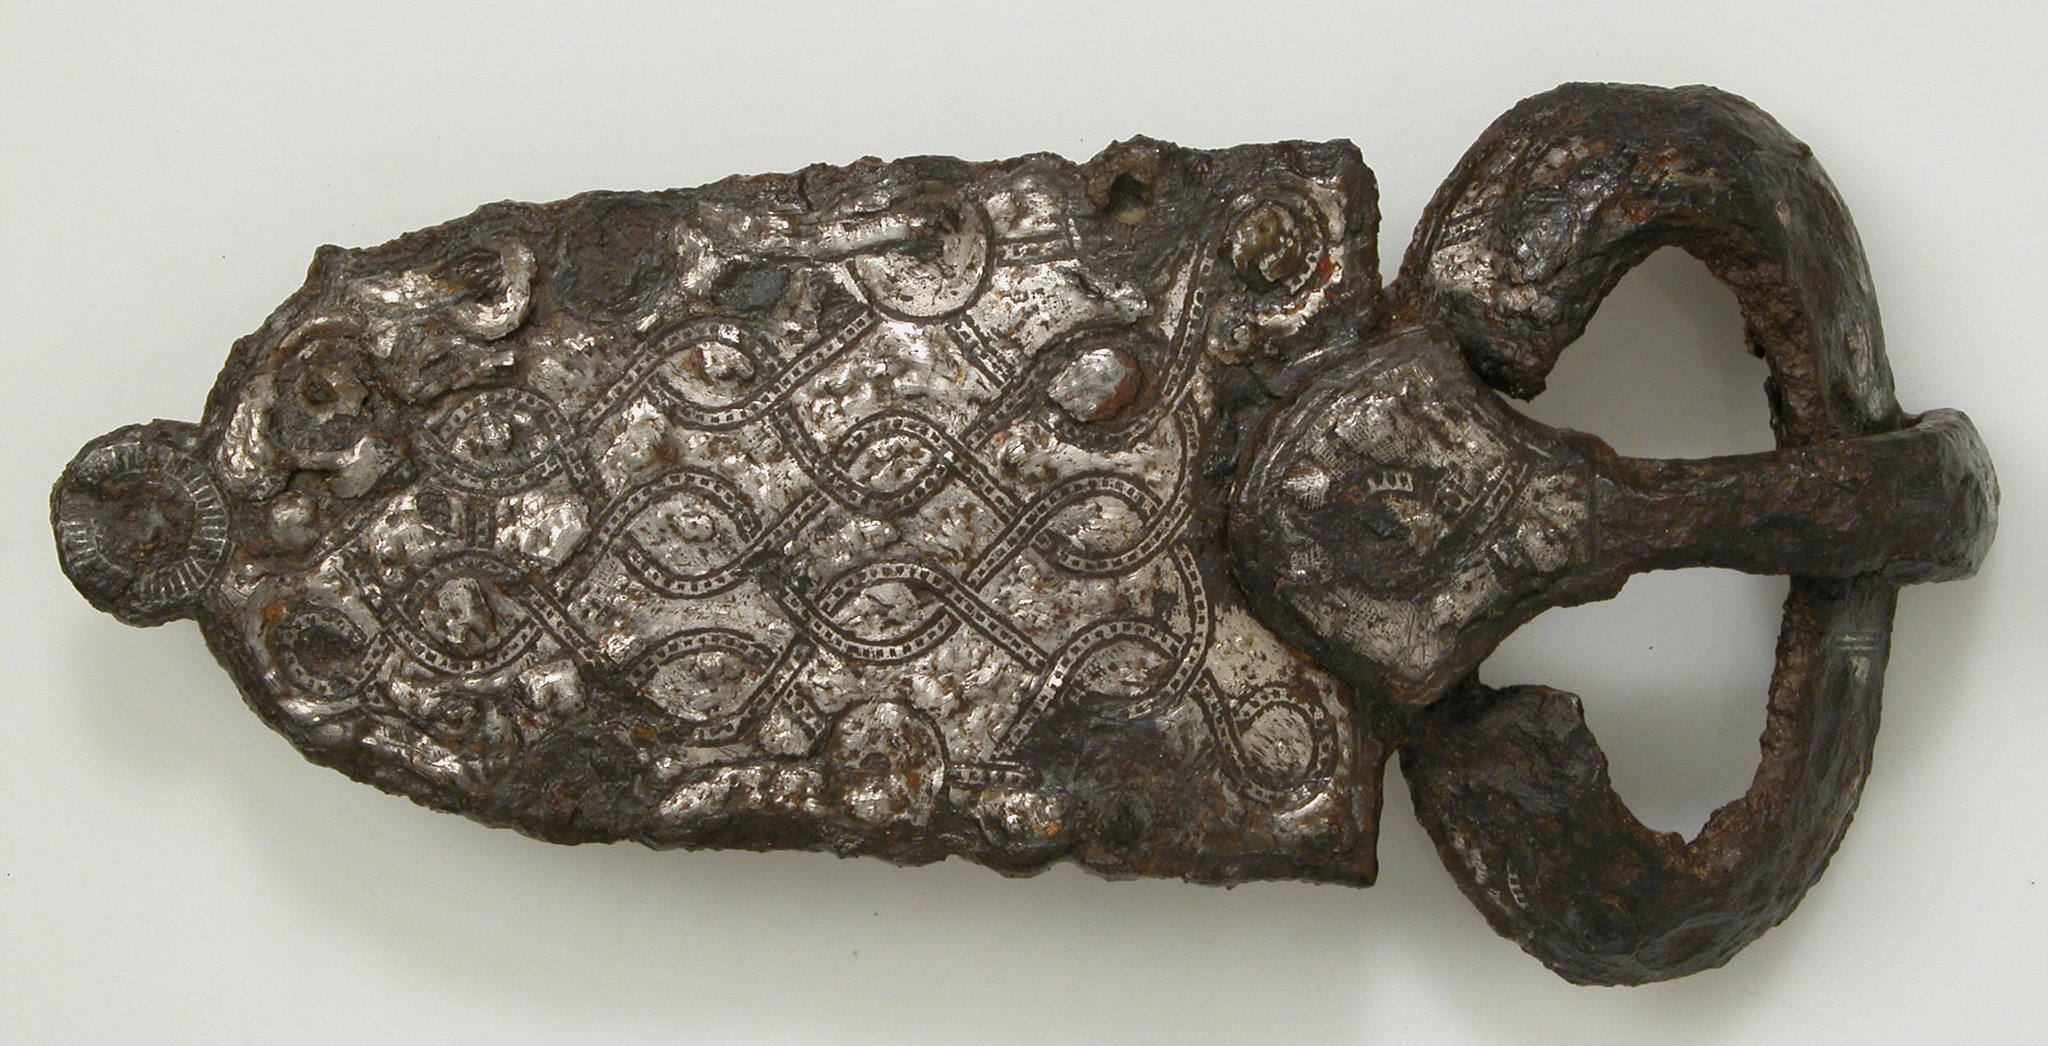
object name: belt buckle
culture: burgundian or frankish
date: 601-700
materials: iron, silver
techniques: inlay